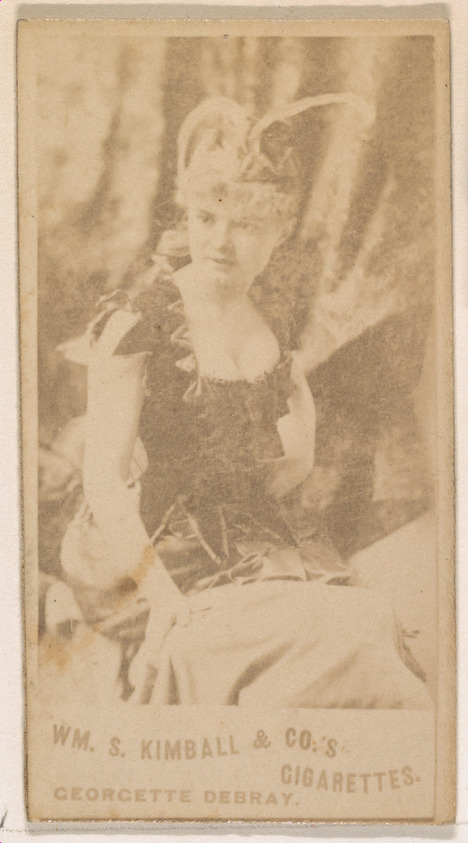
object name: photograph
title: Georgette Debray, from the Actresses series (N203) issued by Wm. S. Kimball & Co.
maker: william s. kimball & company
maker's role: publisher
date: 1889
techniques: color lithograph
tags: portraits,women,actresses